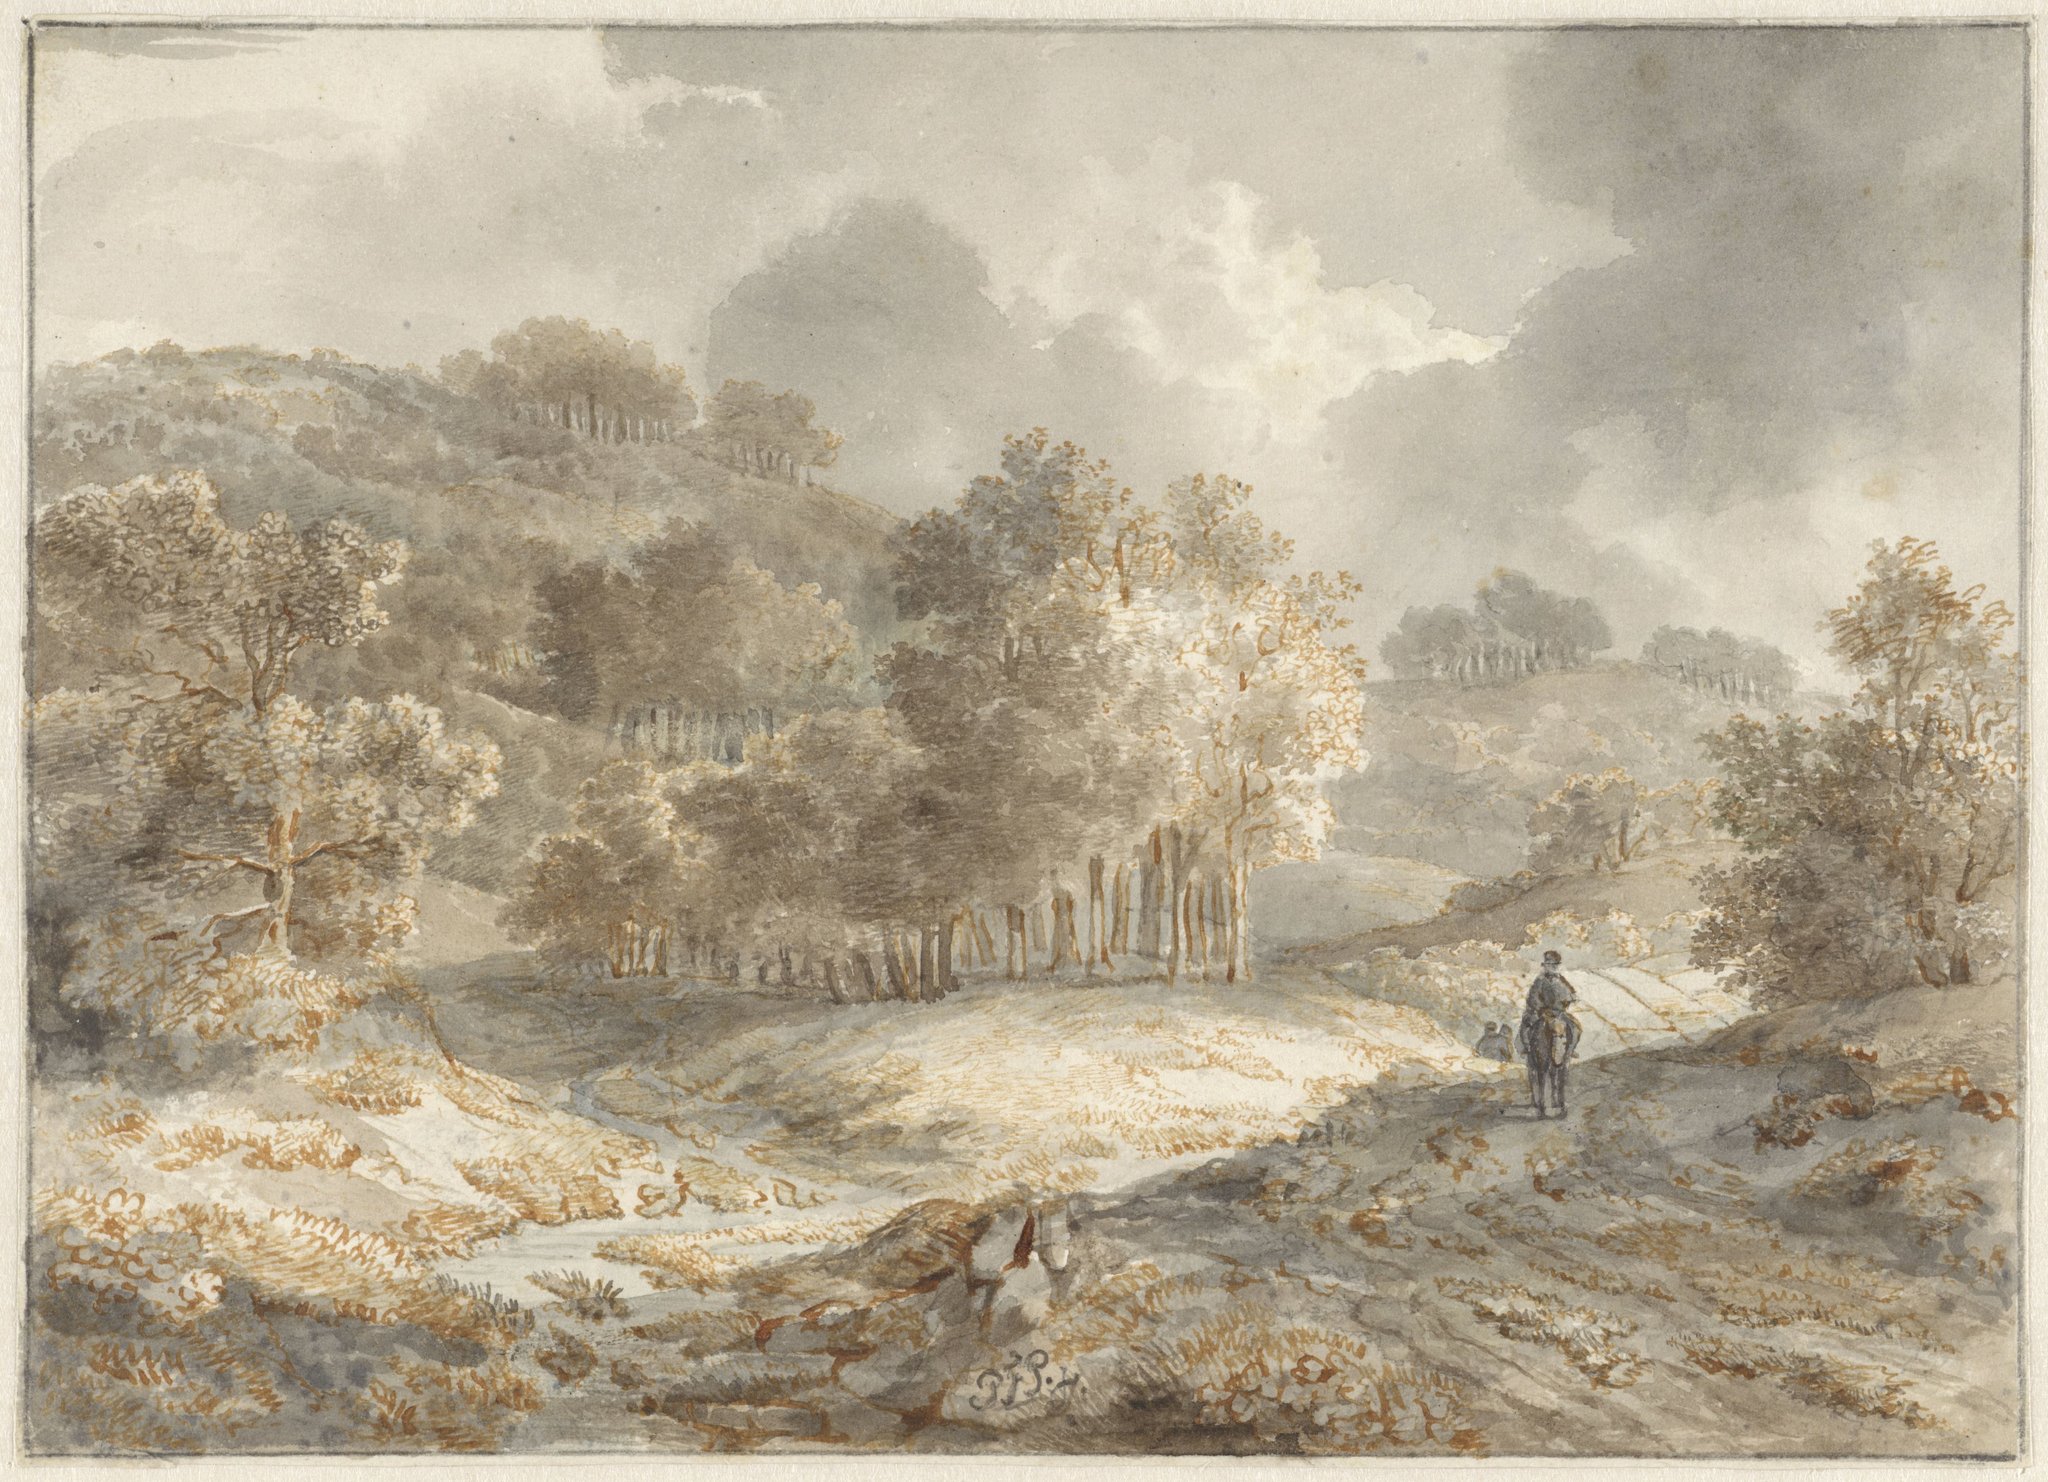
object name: drawing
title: Heuvellandschap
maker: pieter francis peters jr.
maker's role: draughtsman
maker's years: 1818-1903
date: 1828-1903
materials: ink, paper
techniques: brush, pen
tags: low hill country